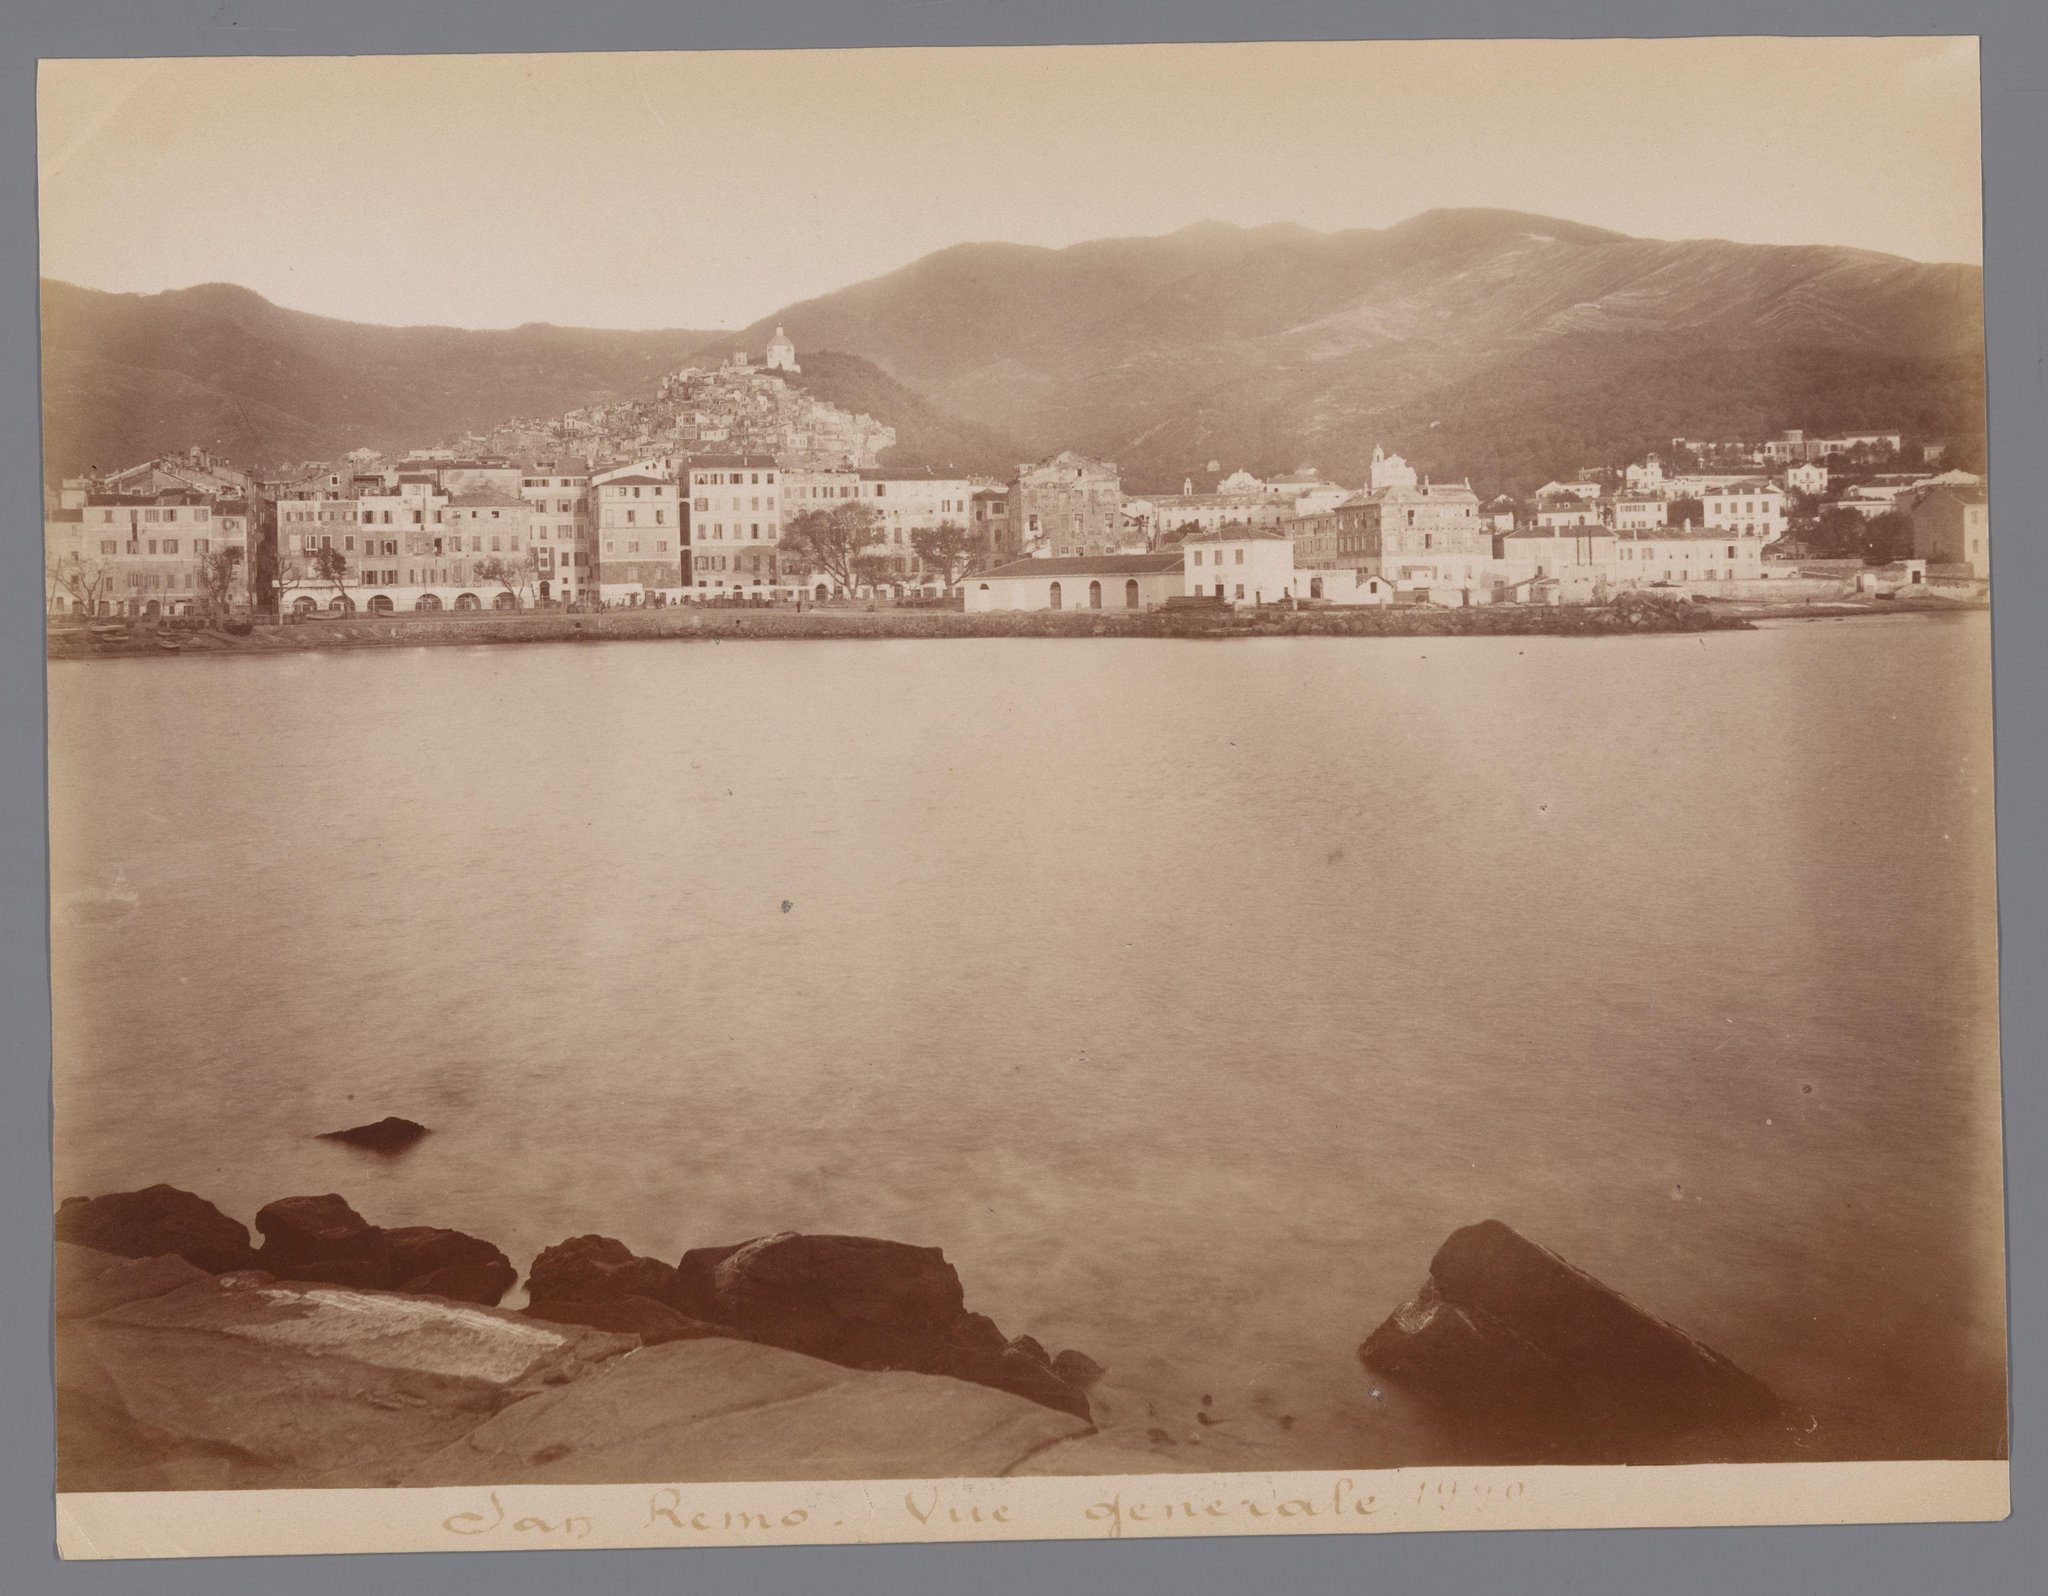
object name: photograph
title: Gezicht op San Remo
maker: Anonymous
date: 1851-1900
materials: paper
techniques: albumen print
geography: san remo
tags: prospect of city, town panorama, silhouette of city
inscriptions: number: ‘1990 [?]’